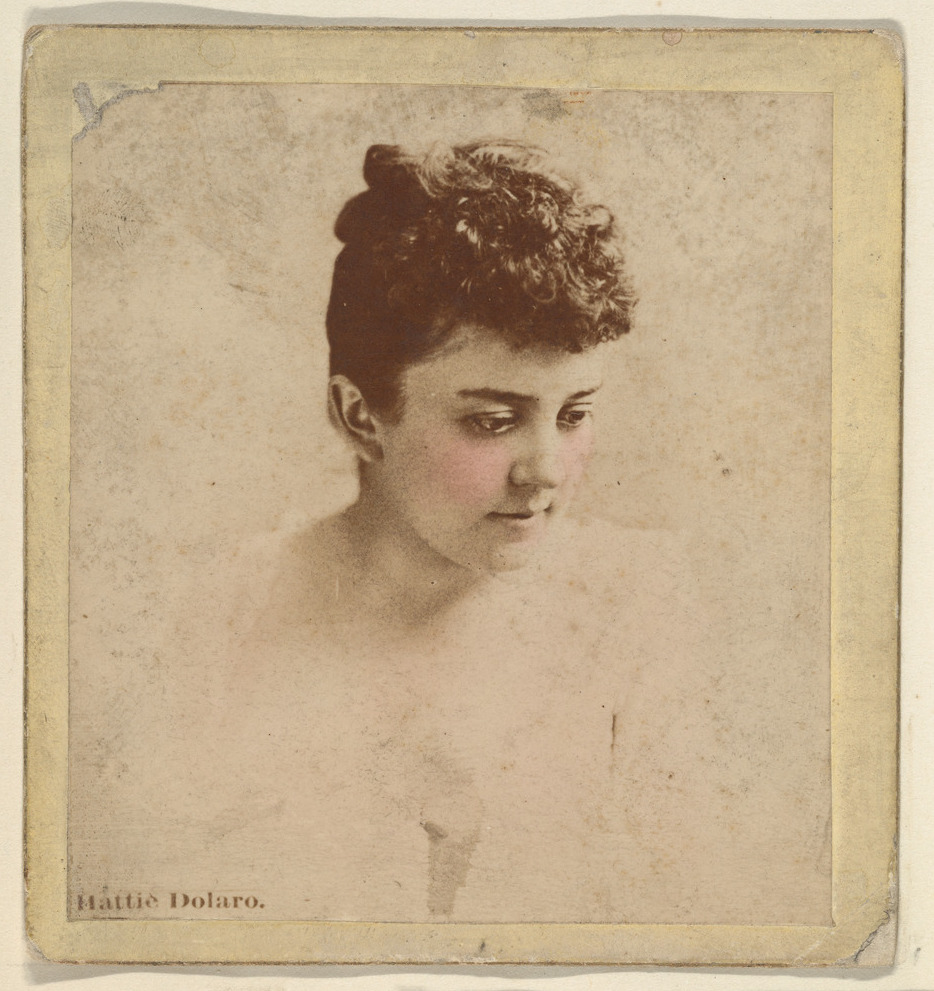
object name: photograph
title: Hattie Dolaro, from the Actresses series (N246), Type 2, issued by Kinney Brothers to promote Sporting Extra Cigarettes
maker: kinney brothers tobacco company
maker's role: publisher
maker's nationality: american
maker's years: 1869-2011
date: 1890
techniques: albumen silver print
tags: portraits,women,actresses